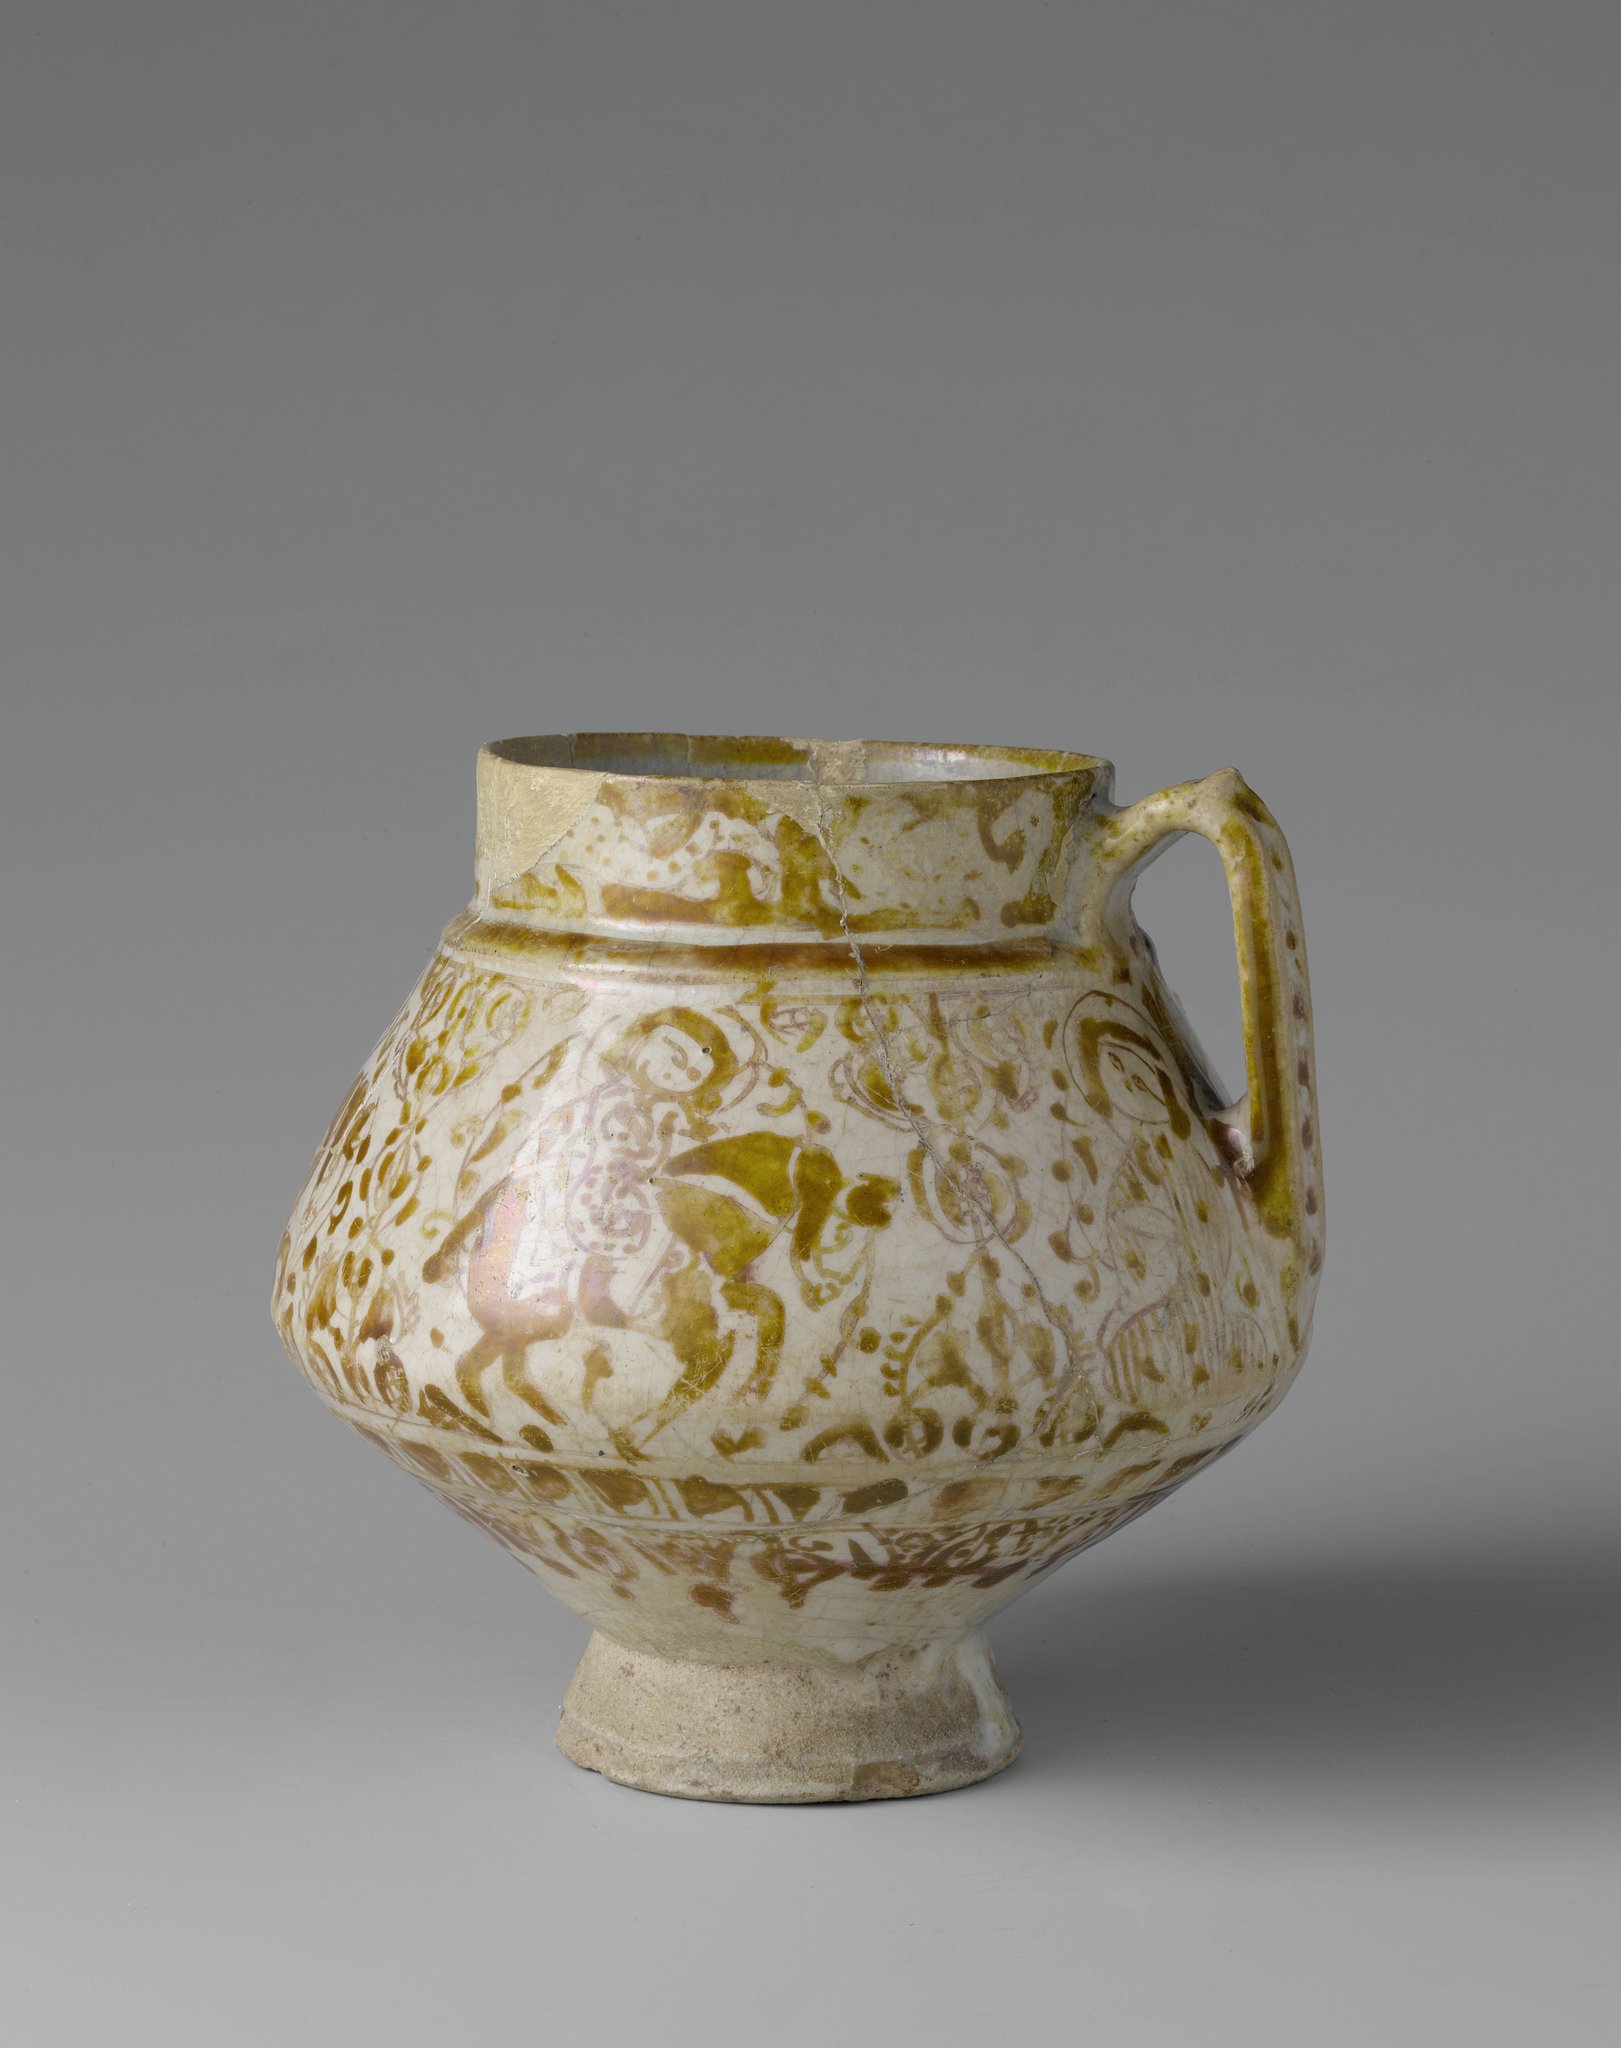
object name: ewer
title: Pear-shaped ewer with horsemen among floral scrolls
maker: Anonymous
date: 1170-1200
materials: earthenware, glaze, luster, paint, quartz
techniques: firing, turning, vitrification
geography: kashan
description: Kwarts-fritgoed kan gedecoreerd met ruiters en bloemranken in luster op ondergrond van opaal wit tin-lood-alkaliglazuur.